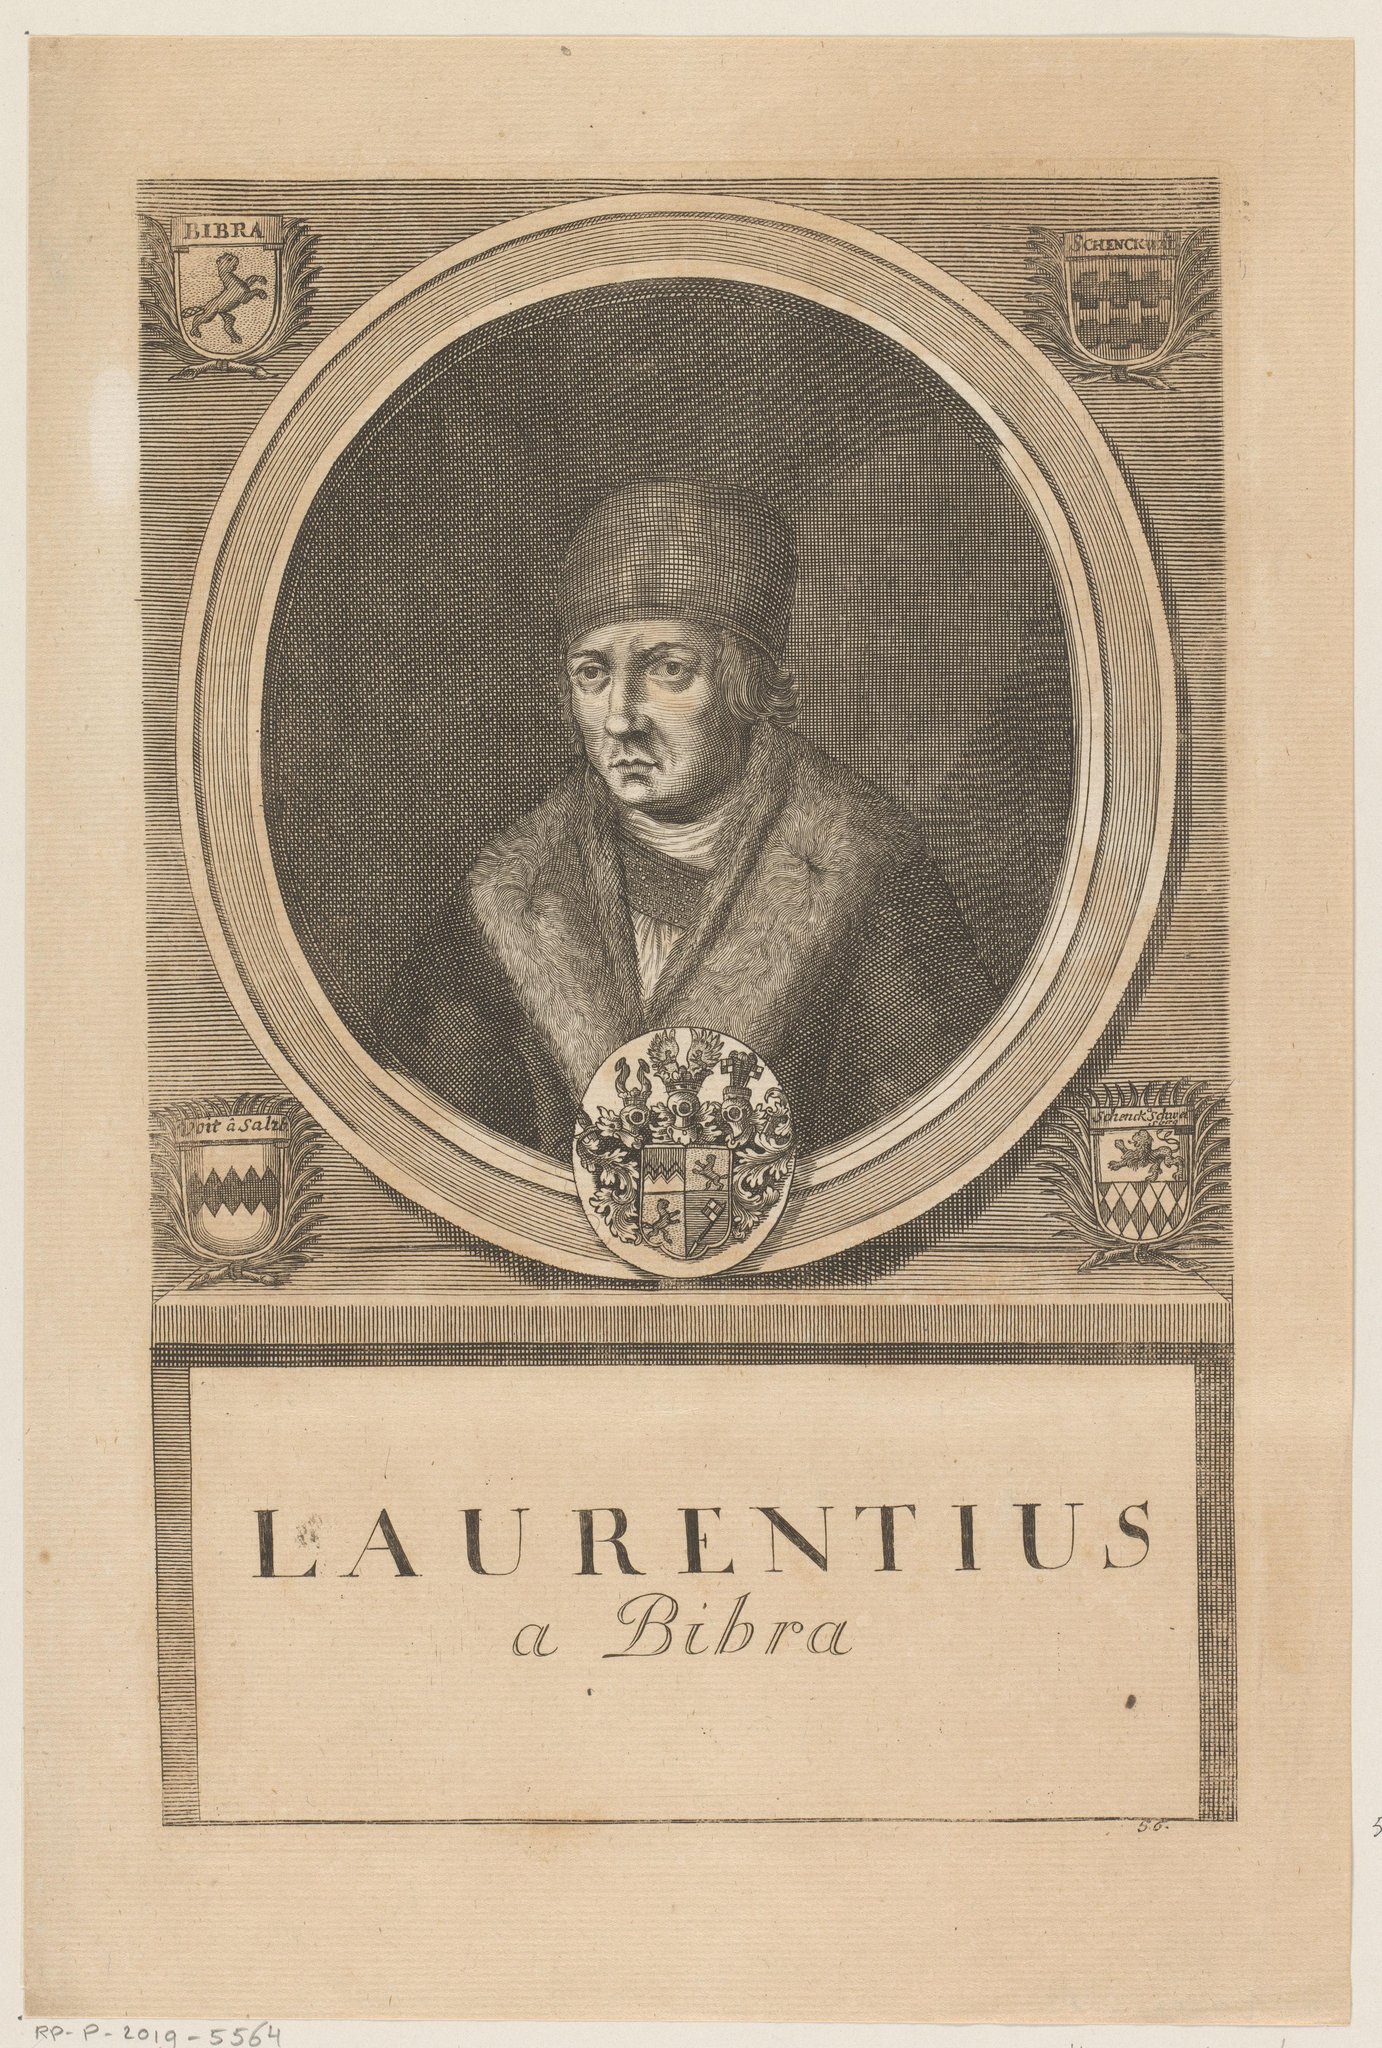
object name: print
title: Laurentius a Bibra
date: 1713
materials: paper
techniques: engraving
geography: frankfurt am main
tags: archbishop, bishop, etc. (roman catholic), historical persons, armorial bearing, heraldry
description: Prent uit: Ludewig, Johann Peter von. Geschicht-Schreiber von dem Bischoffthum Wirtzburg (...). Frankfurt am Main: Thomas Fritsch, 1713.